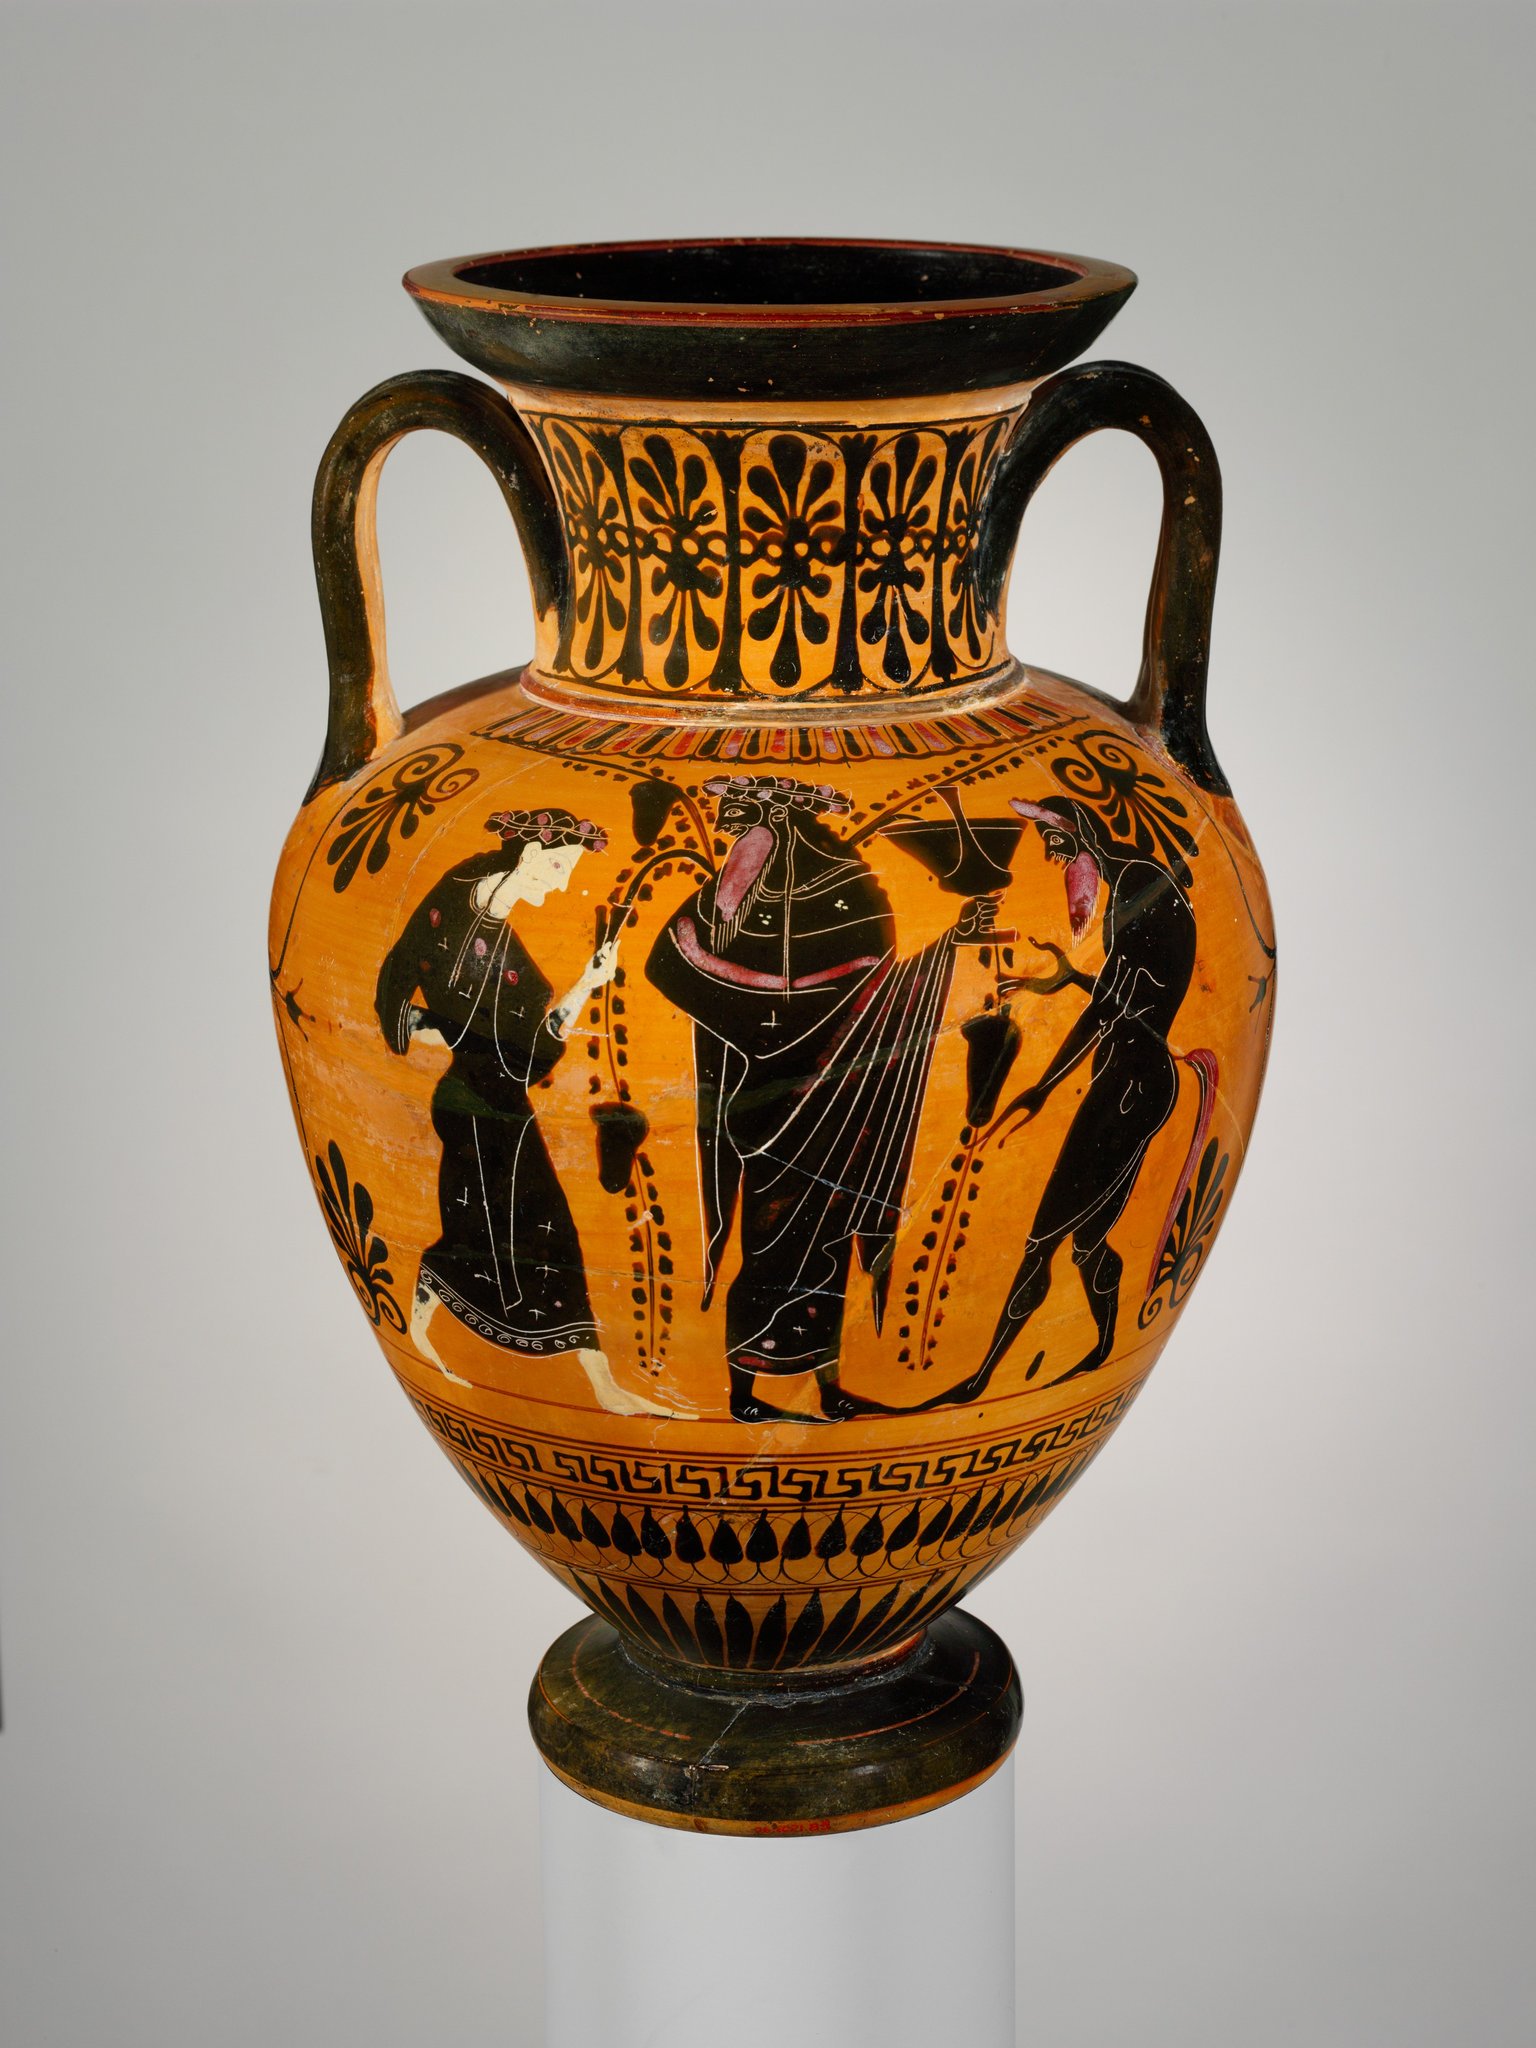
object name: neck amphora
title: Terracotta neck-amphora (jar)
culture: greek, attic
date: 510 BCE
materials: terracotta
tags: dionysus,maenads,satyrs,horses